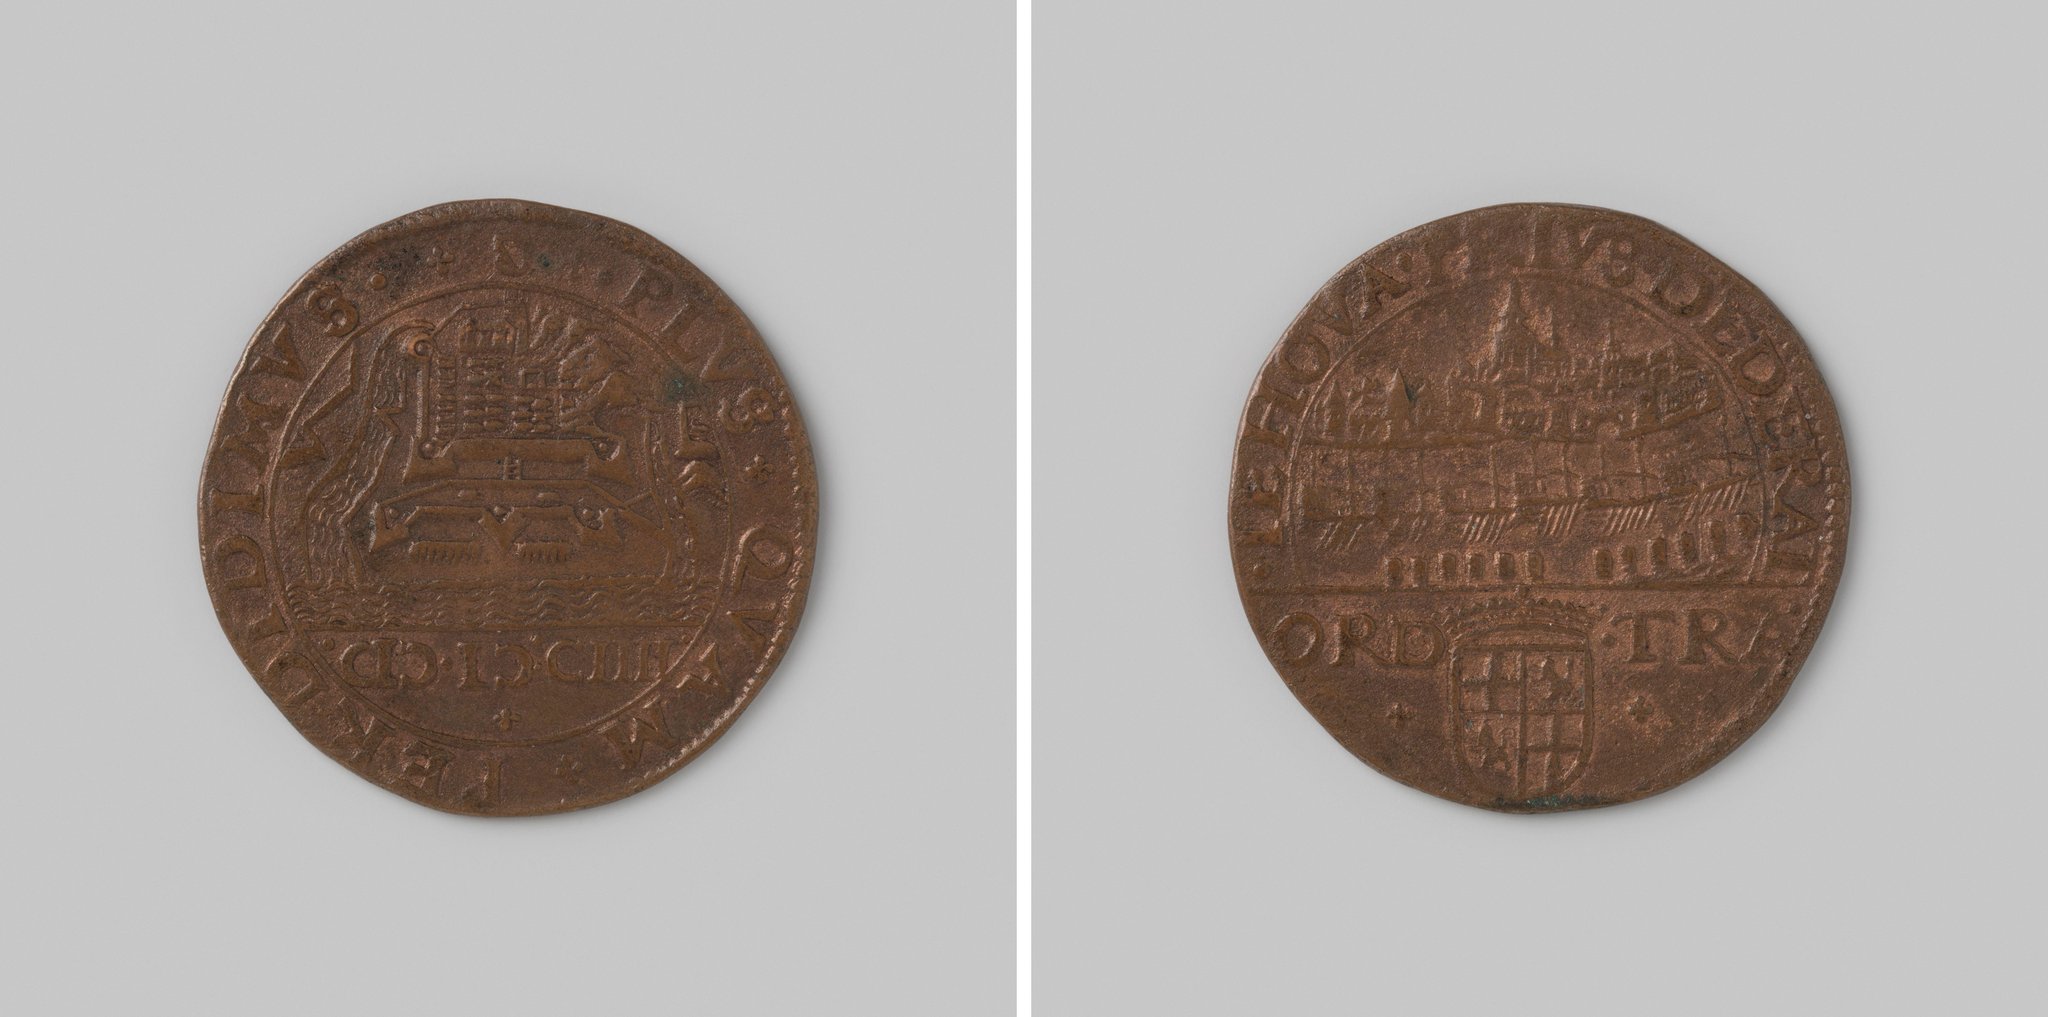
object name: jeton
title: Rekenpenning uit Utrecht voor de Staten van Utrecht op de inname van Sluis en de overgave van Ostende 1604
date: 1604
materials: copper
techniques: striking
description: Koperen penning, op de voorzijde de plattegrond van Ostende met afsnedetekst en omschrift, op de keerzijde het aanzicht van Sluis, met afsnedetekst en omschrift.